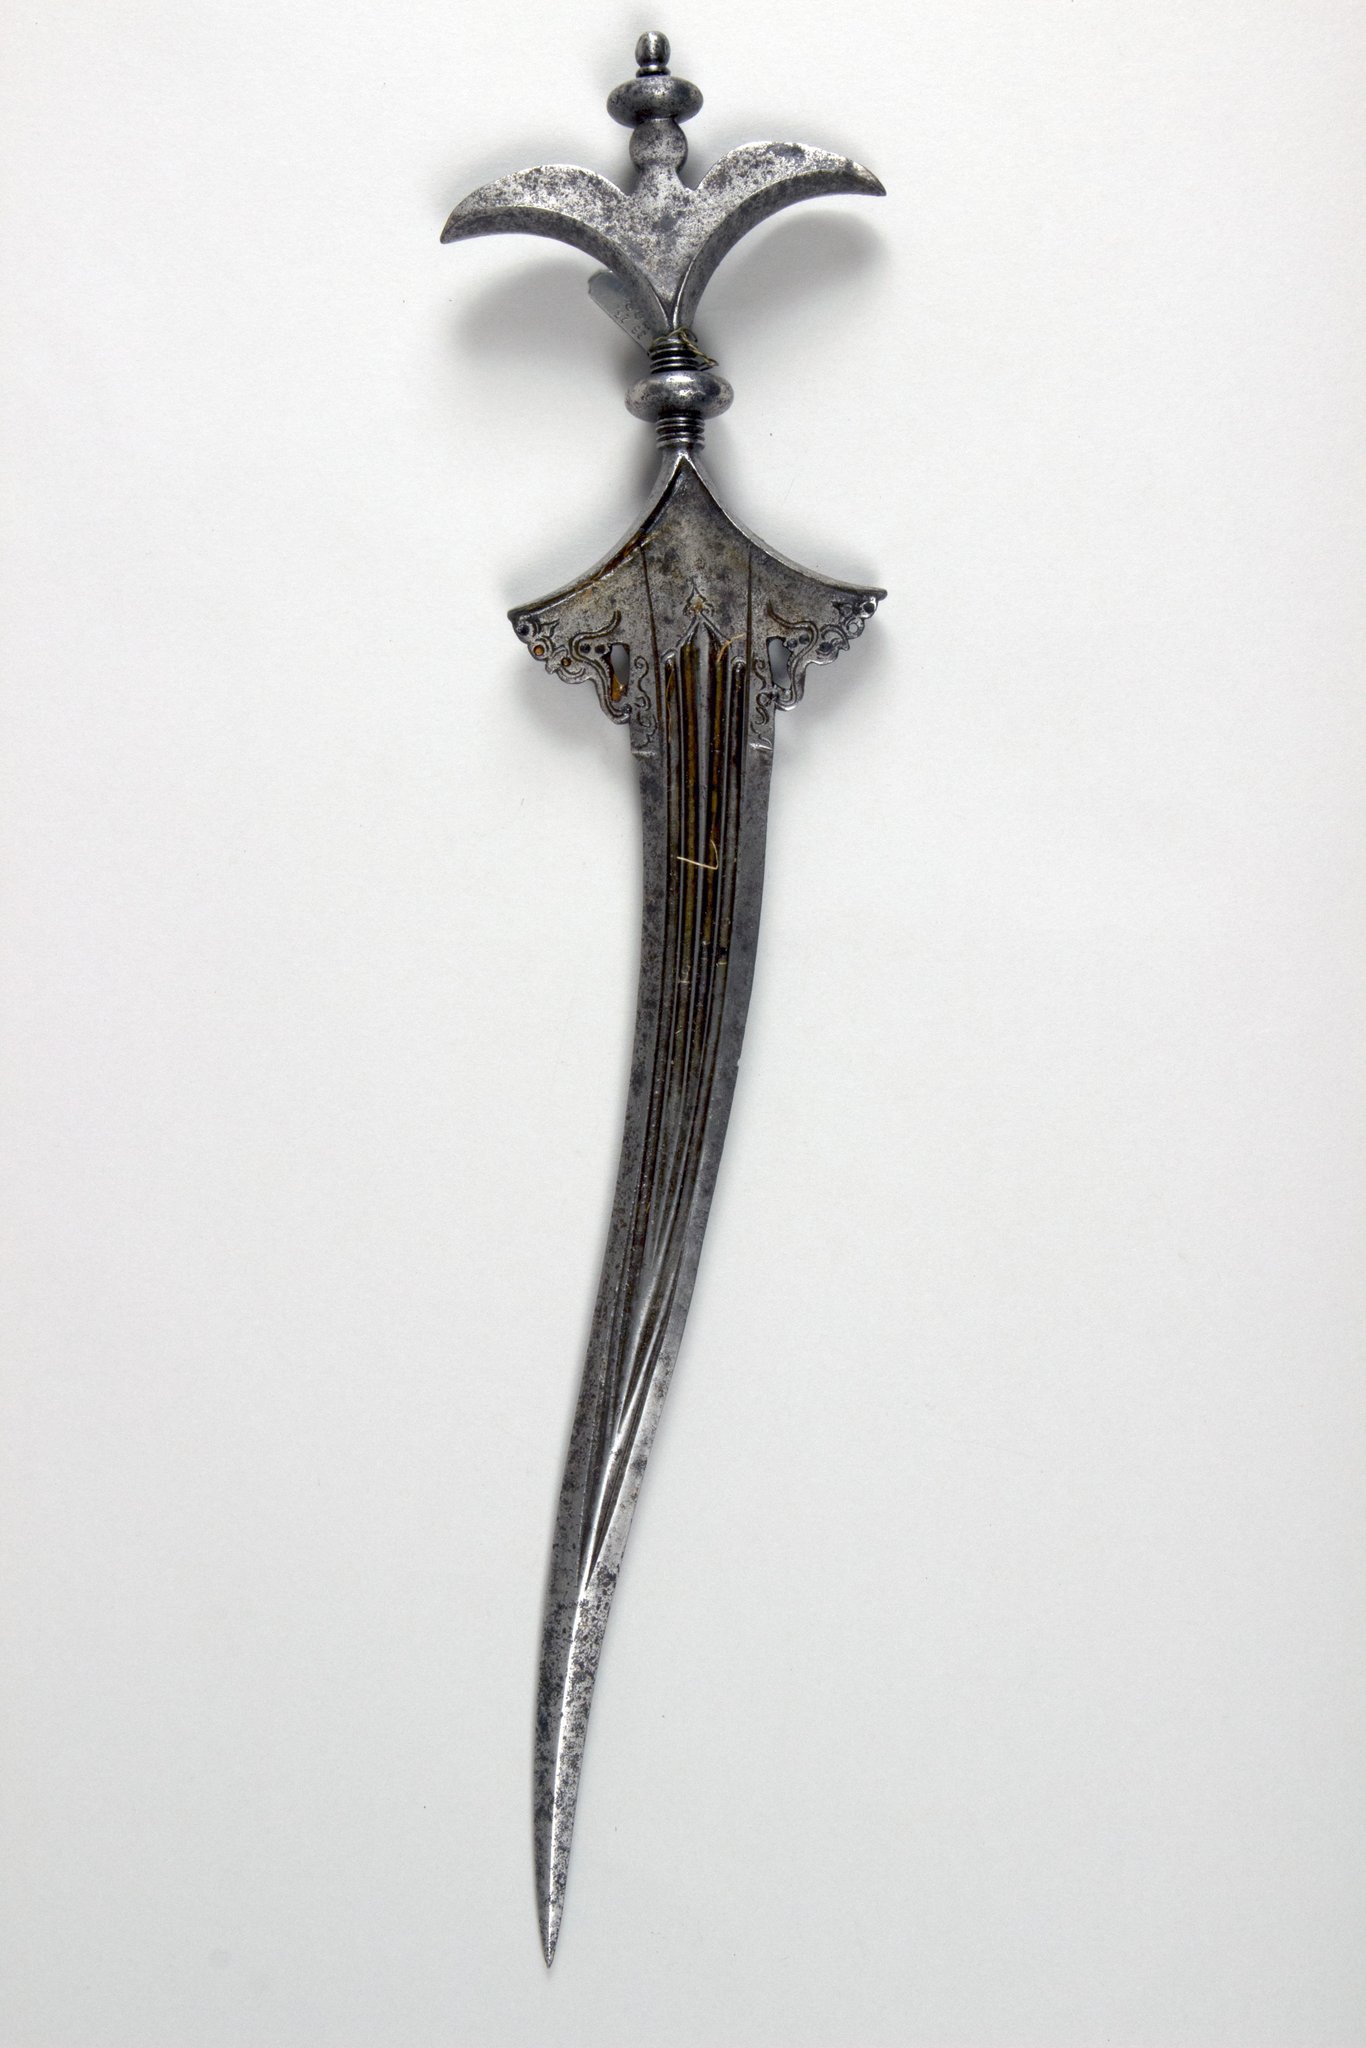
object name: dagger chilanum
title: Dagger (Chilanum)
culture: indian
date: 1601-1700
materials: steel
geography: india